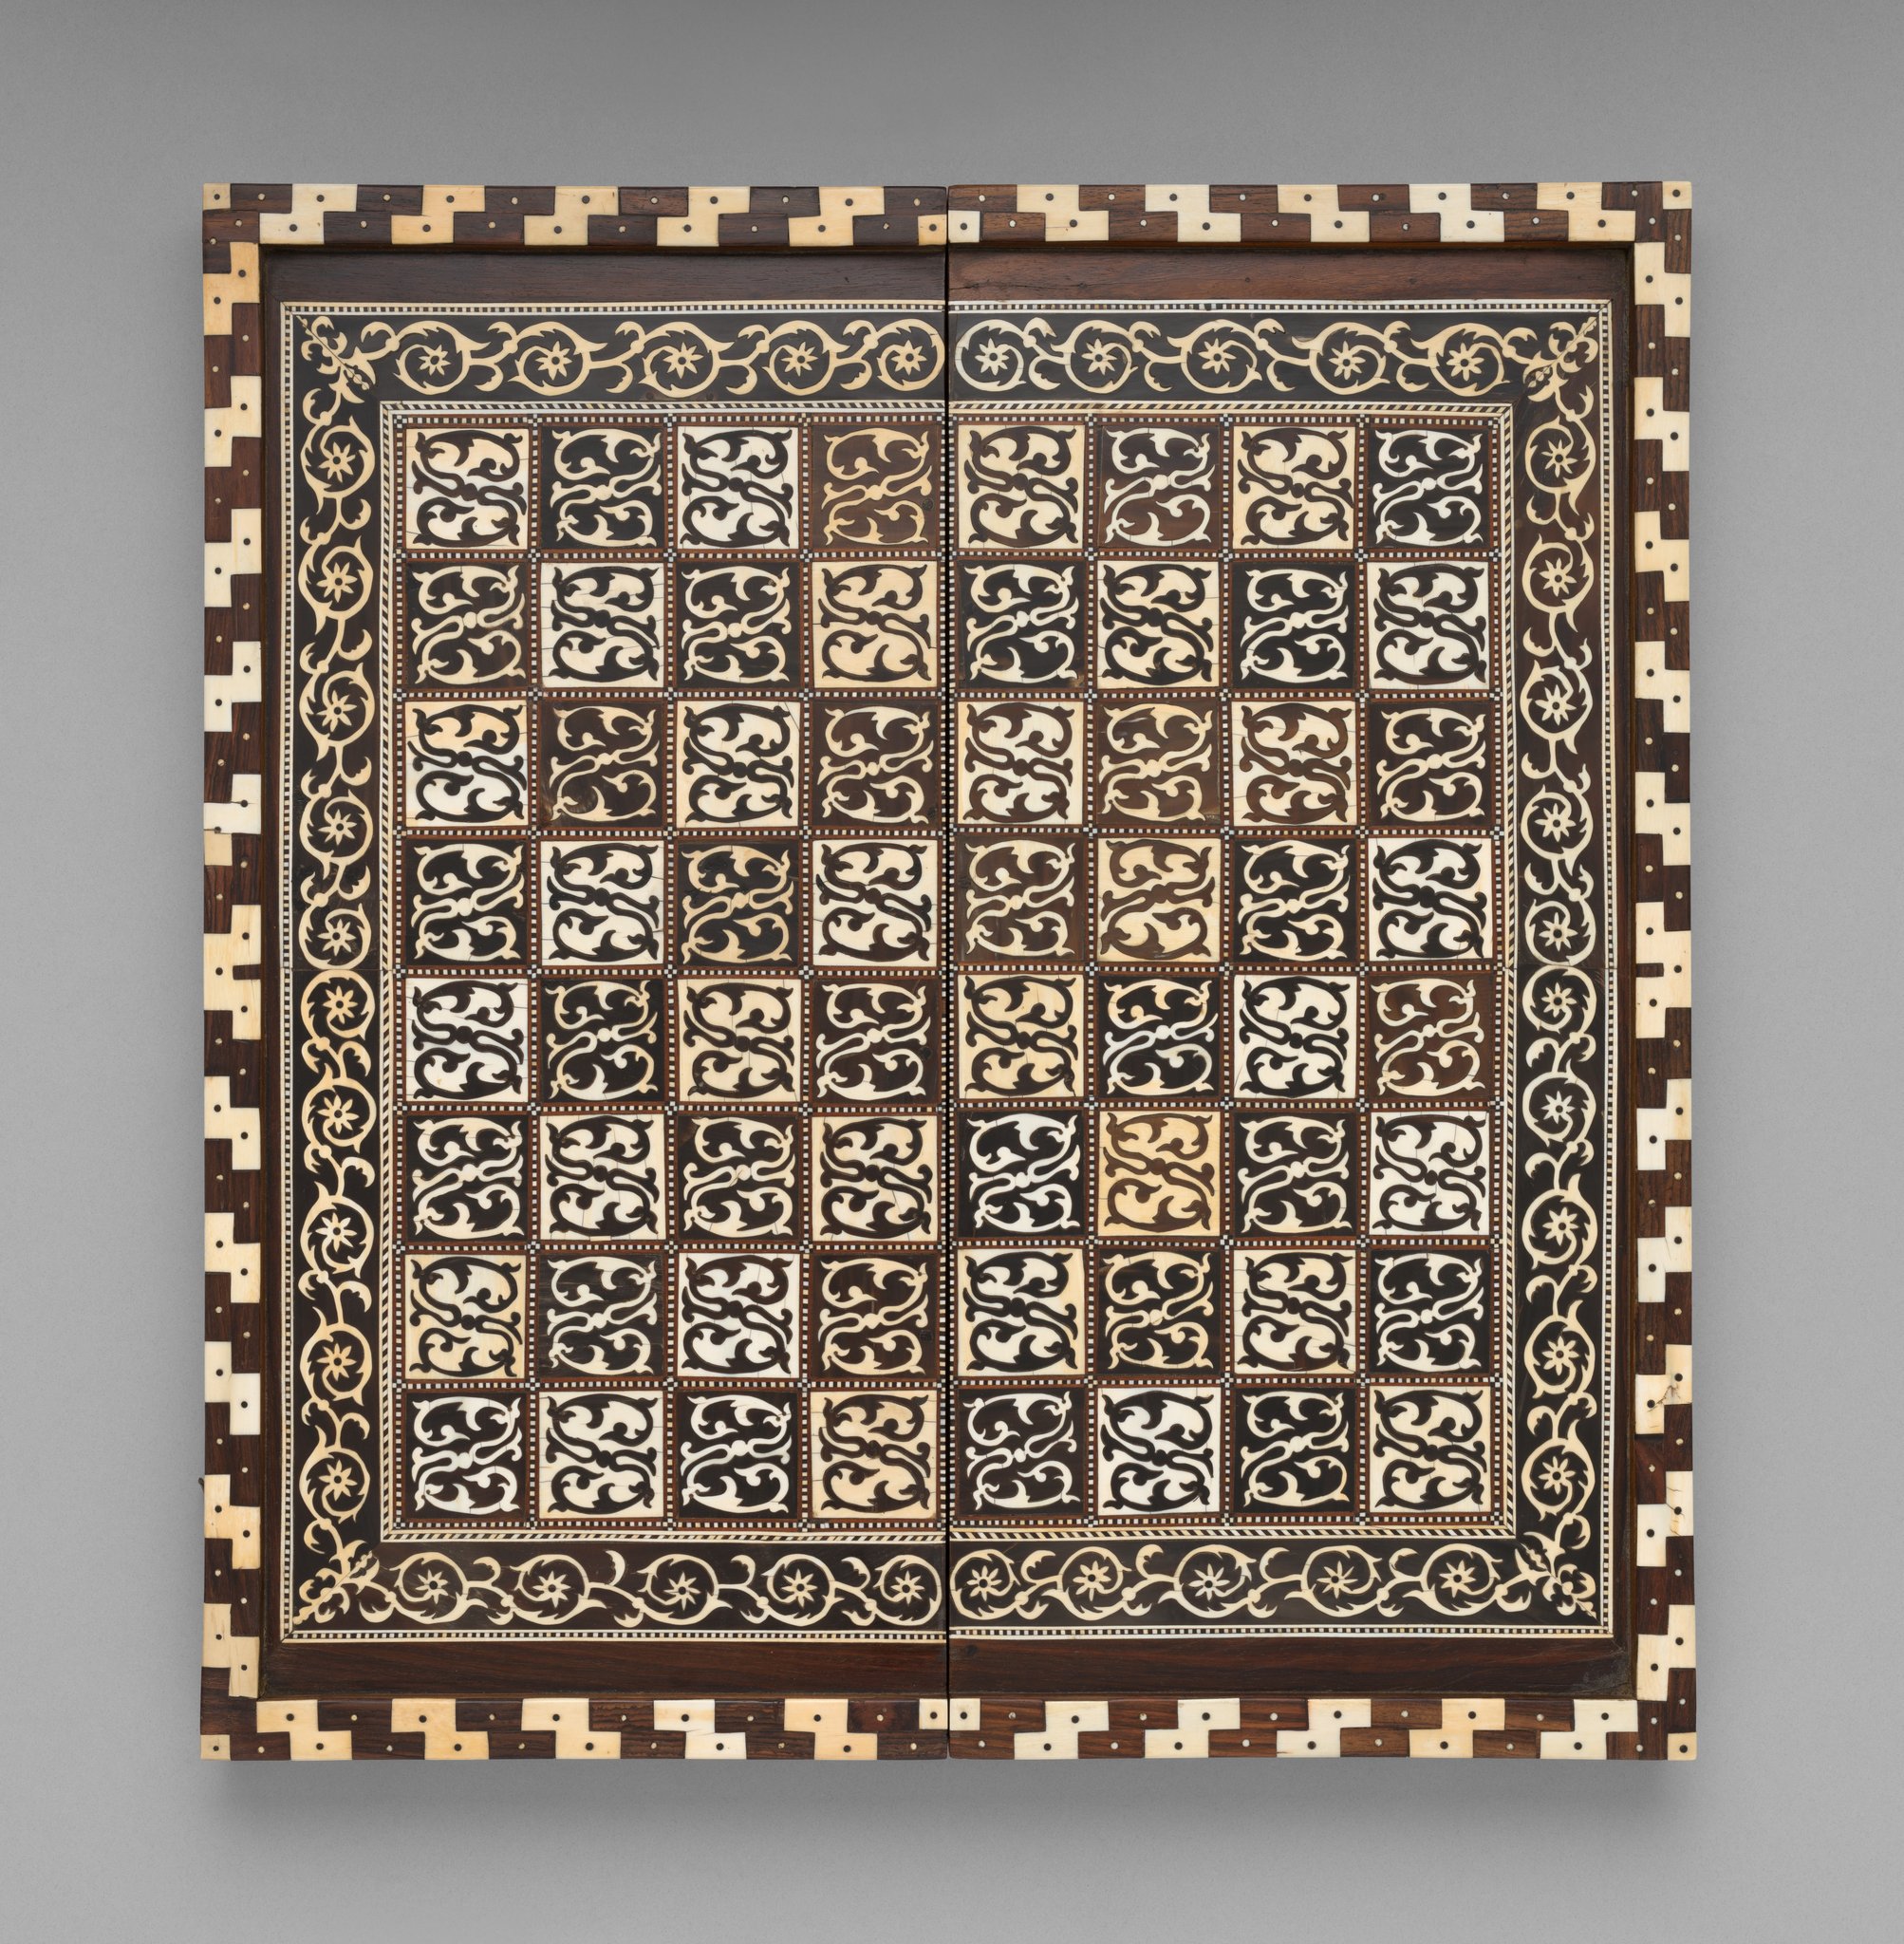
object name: chess and backgammon board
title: Box-board for chess and backgammon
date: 1801-1833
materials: ivory, shell, wood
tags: games